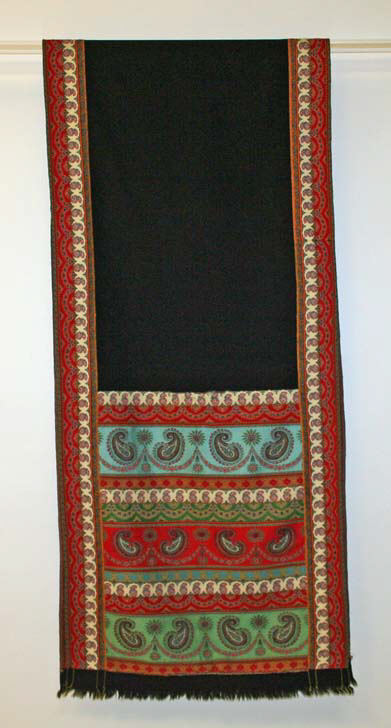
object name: scarf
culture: european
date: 1860-1865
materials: wool